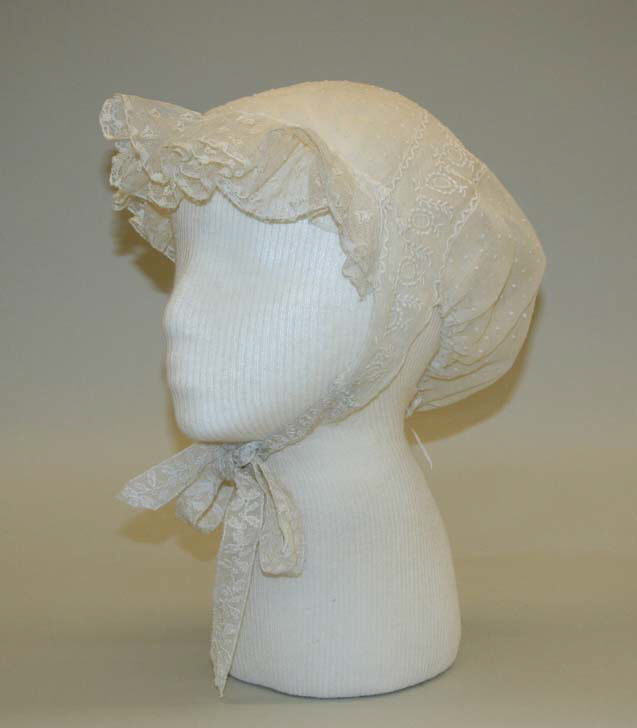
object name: cap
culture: american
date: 1813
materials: cotton